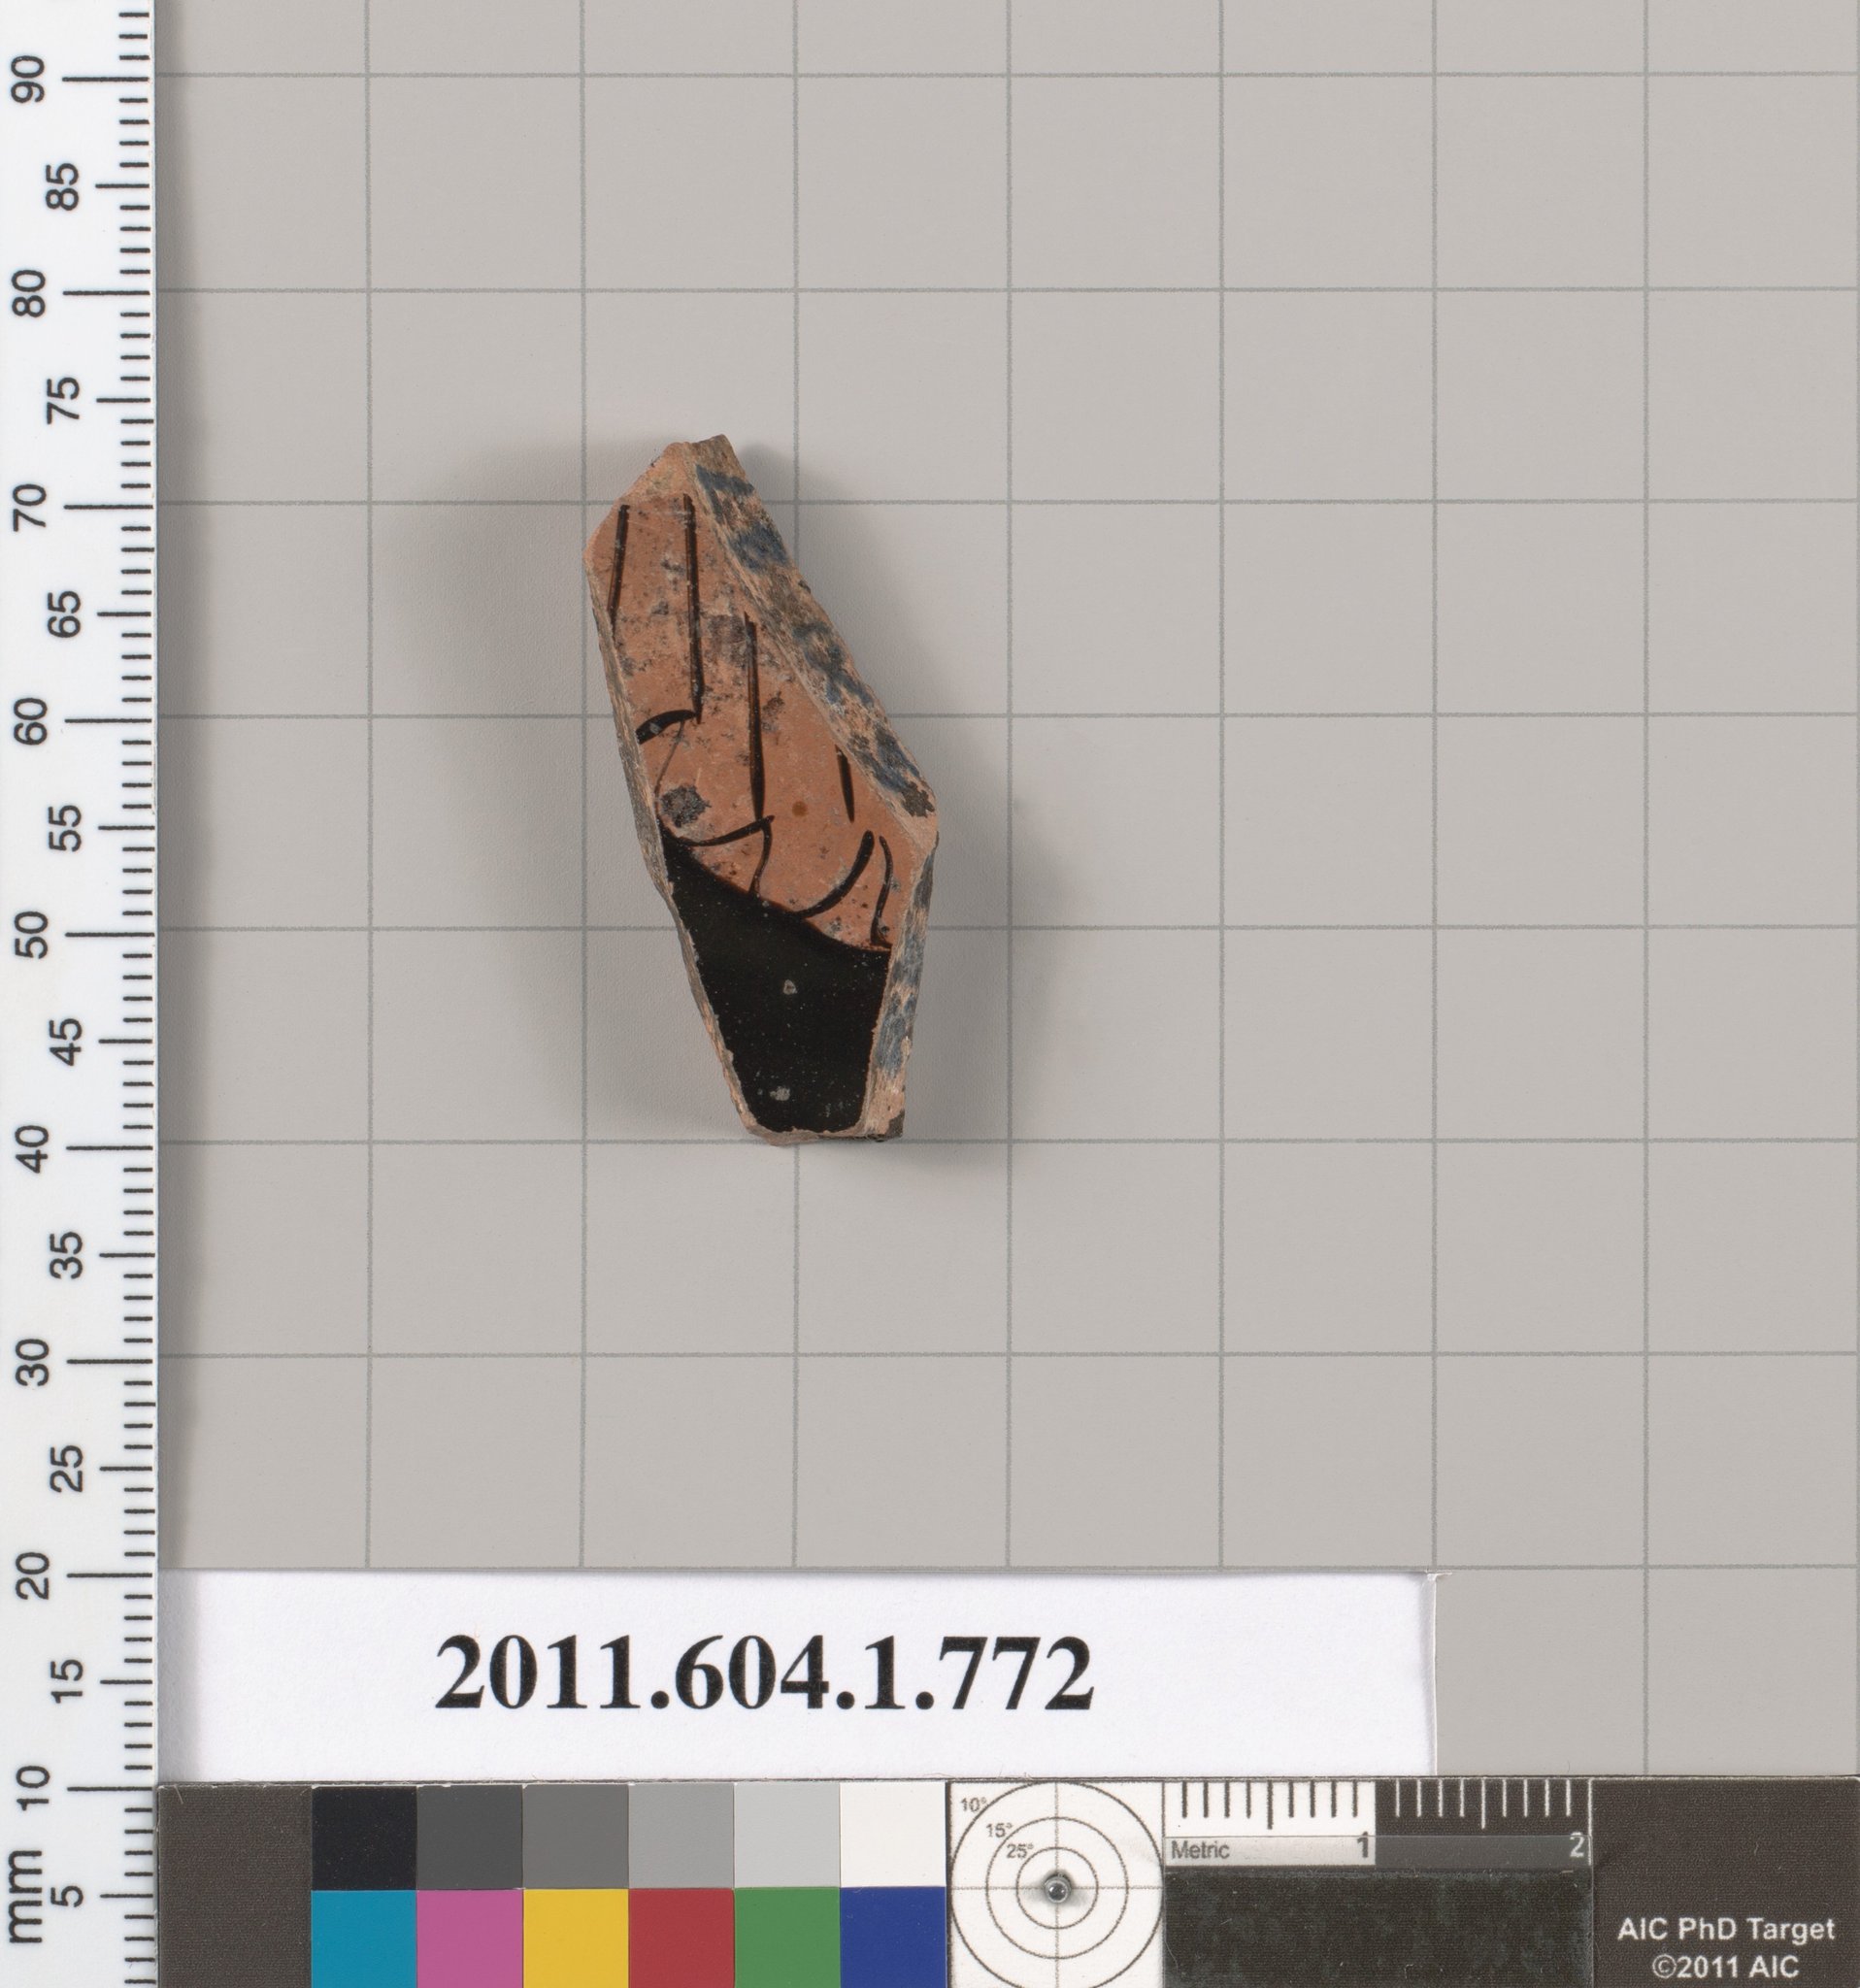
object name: kylix fragment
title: Terracotta fragment of a kylix (drinking cup)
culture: greek, attic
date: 475-451 BCE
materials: terracotta